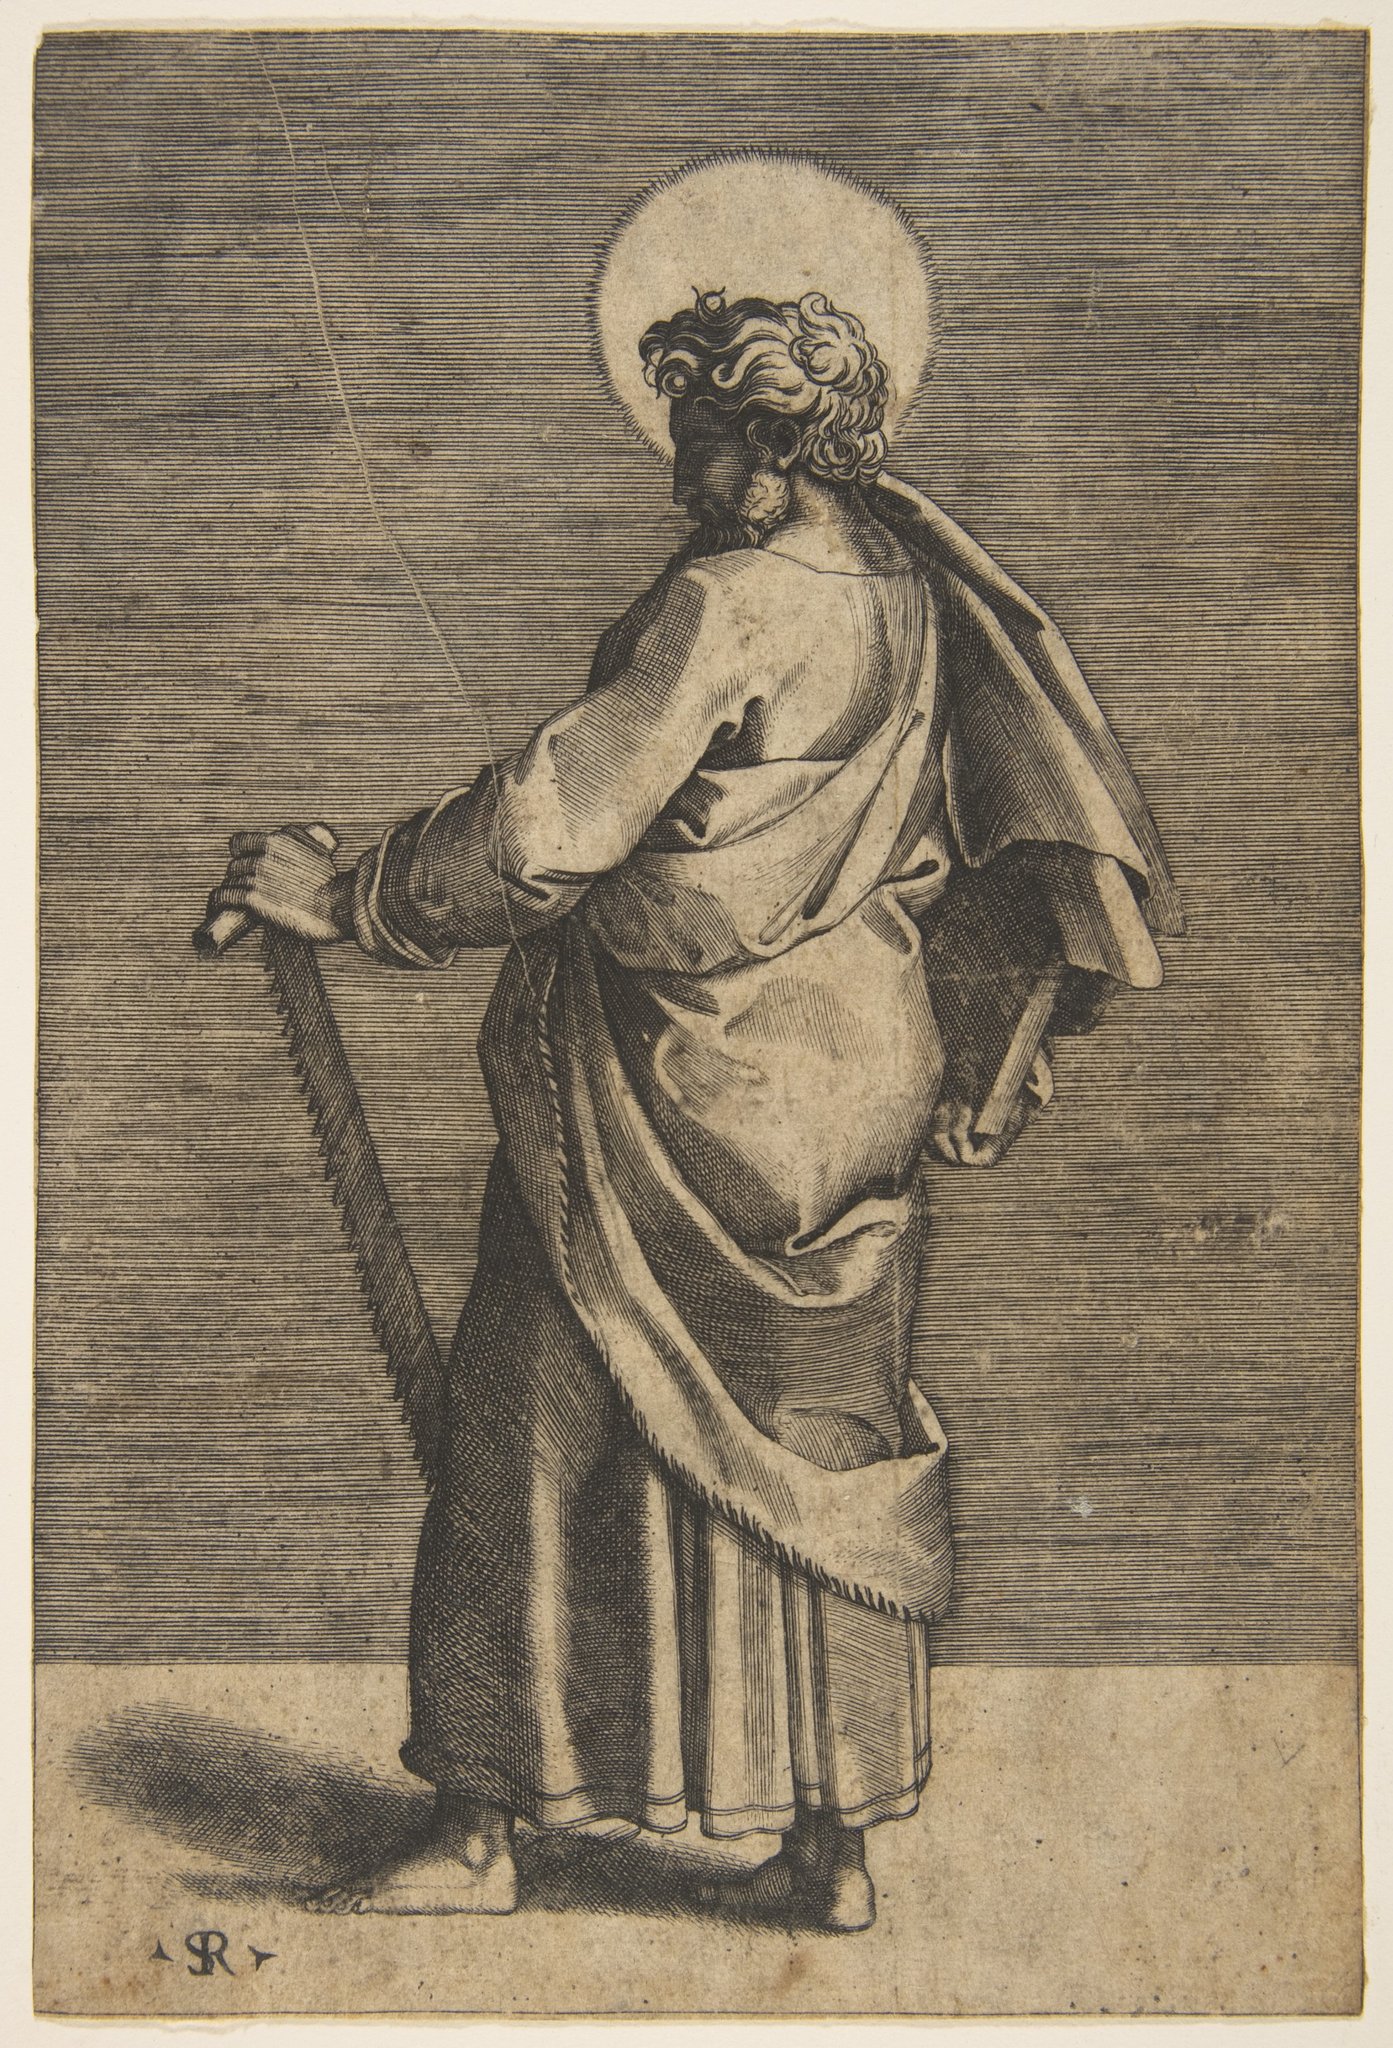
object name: print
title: Saint Simon standing facing left, holding a saw and a book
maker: marco dente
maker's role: artist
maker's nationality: italian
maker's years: 1515-1527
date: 1515-1527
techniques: engraving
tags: books,men,saints,tools